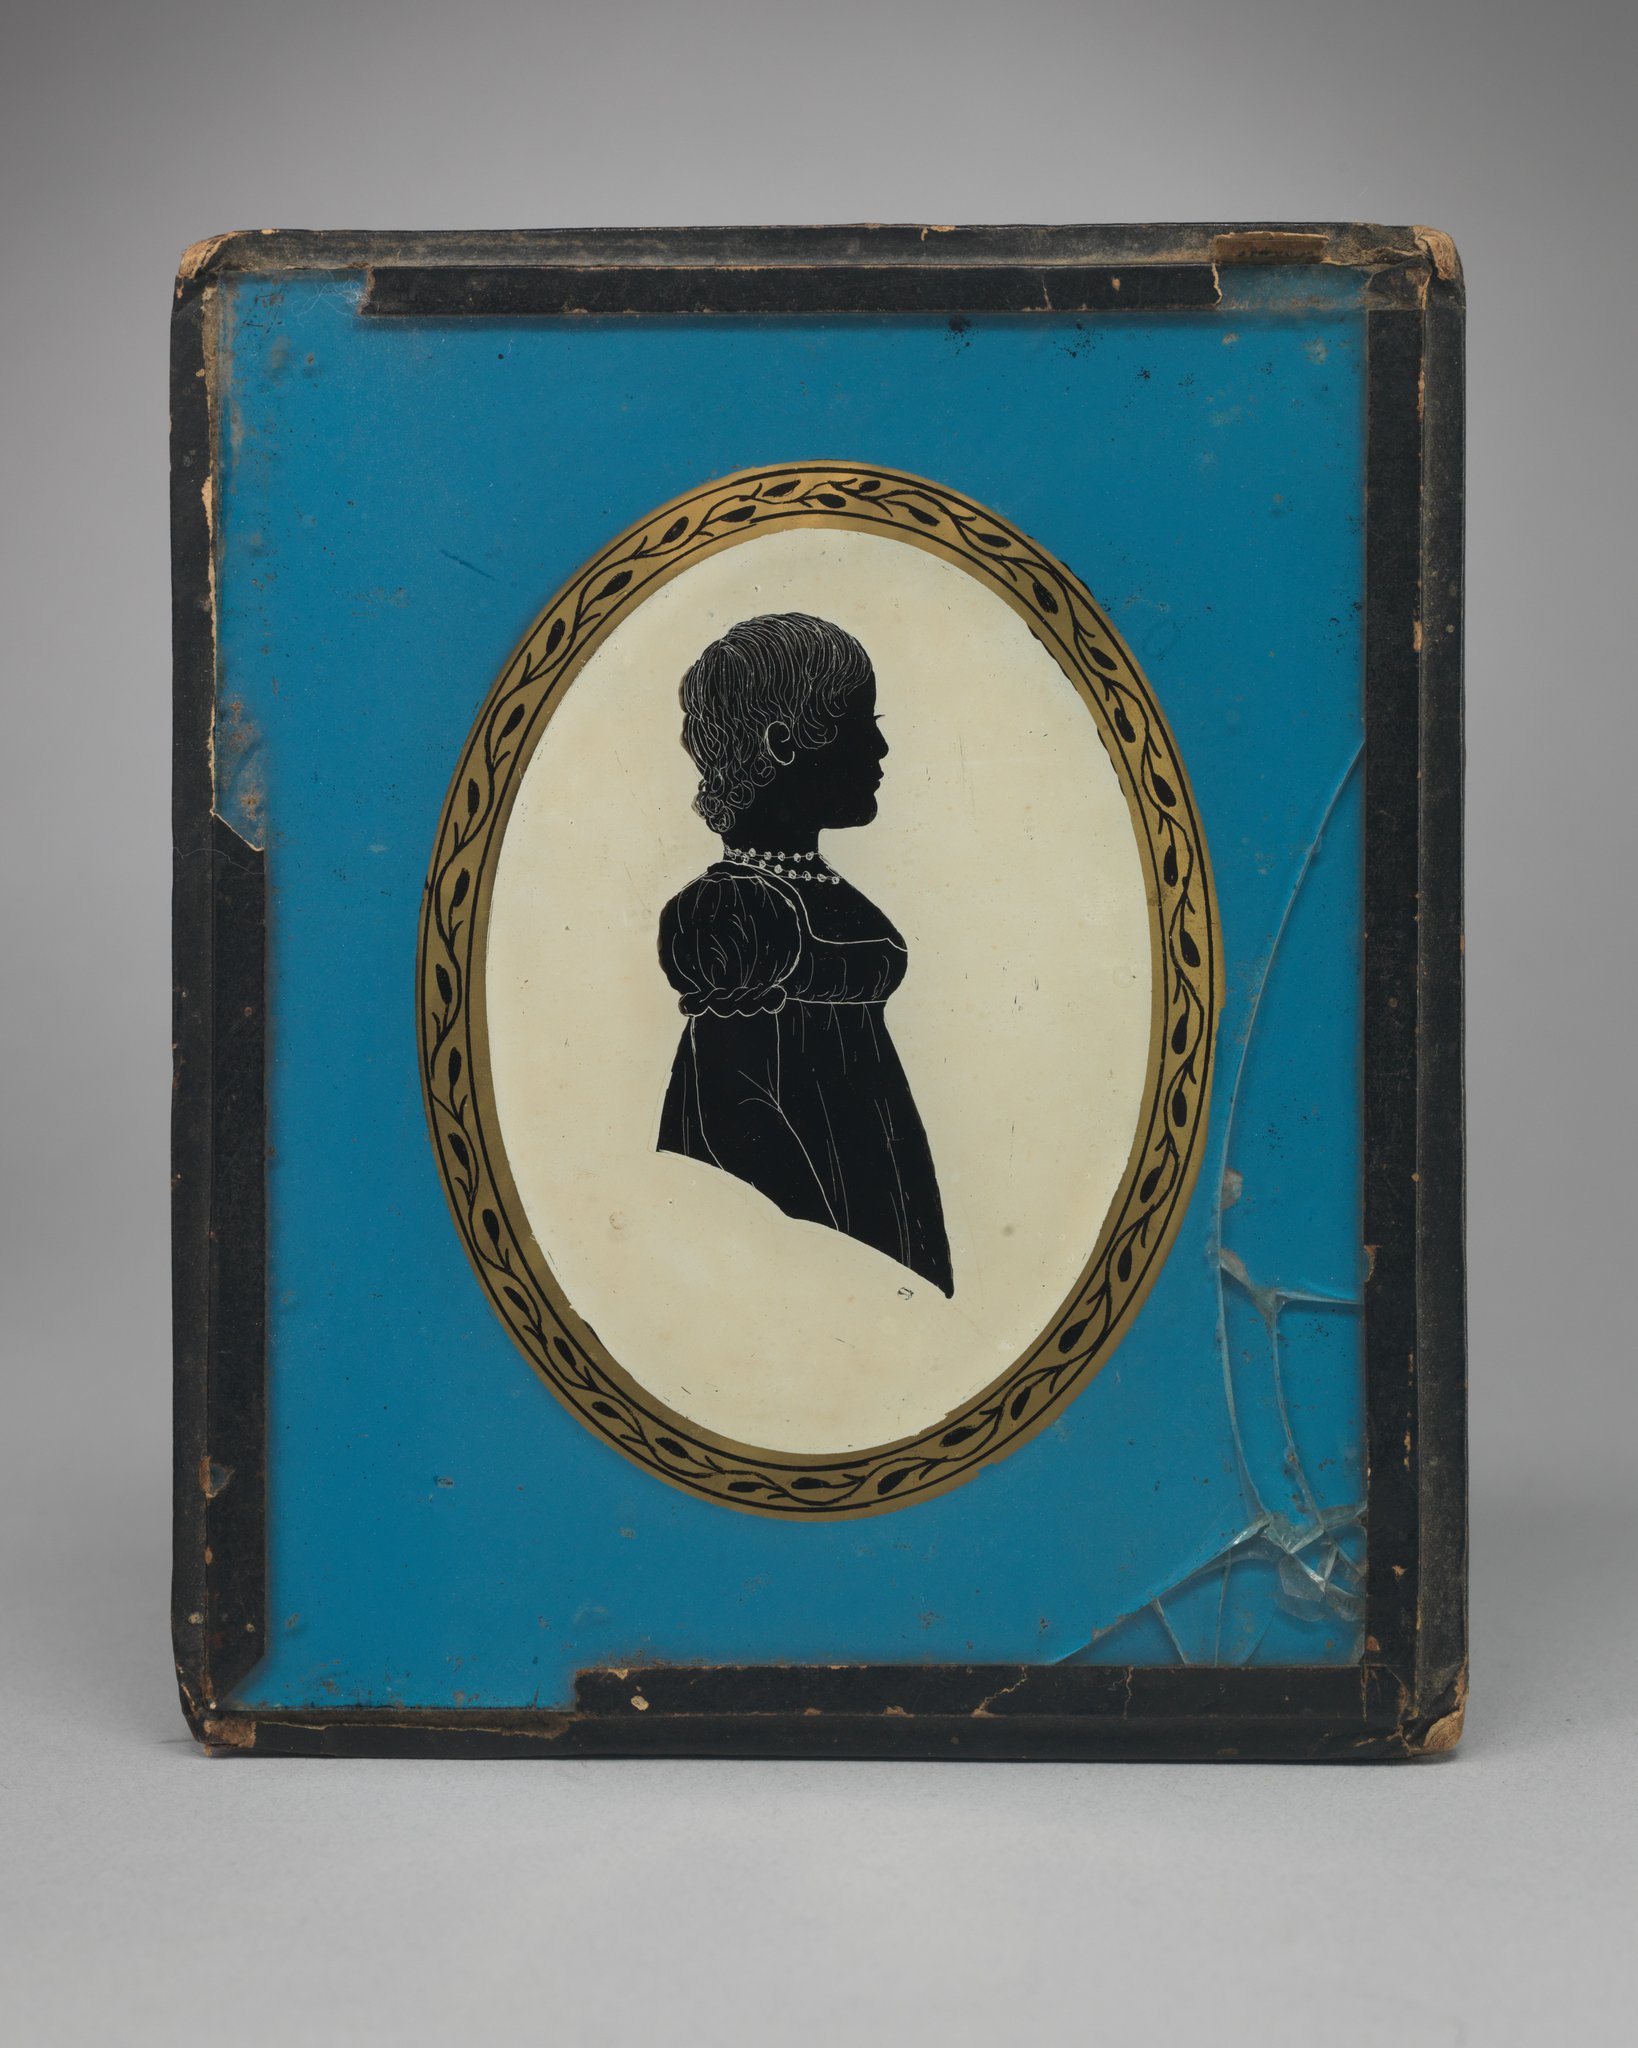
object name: medallion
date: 1801-1900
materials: glass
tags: profiles,women